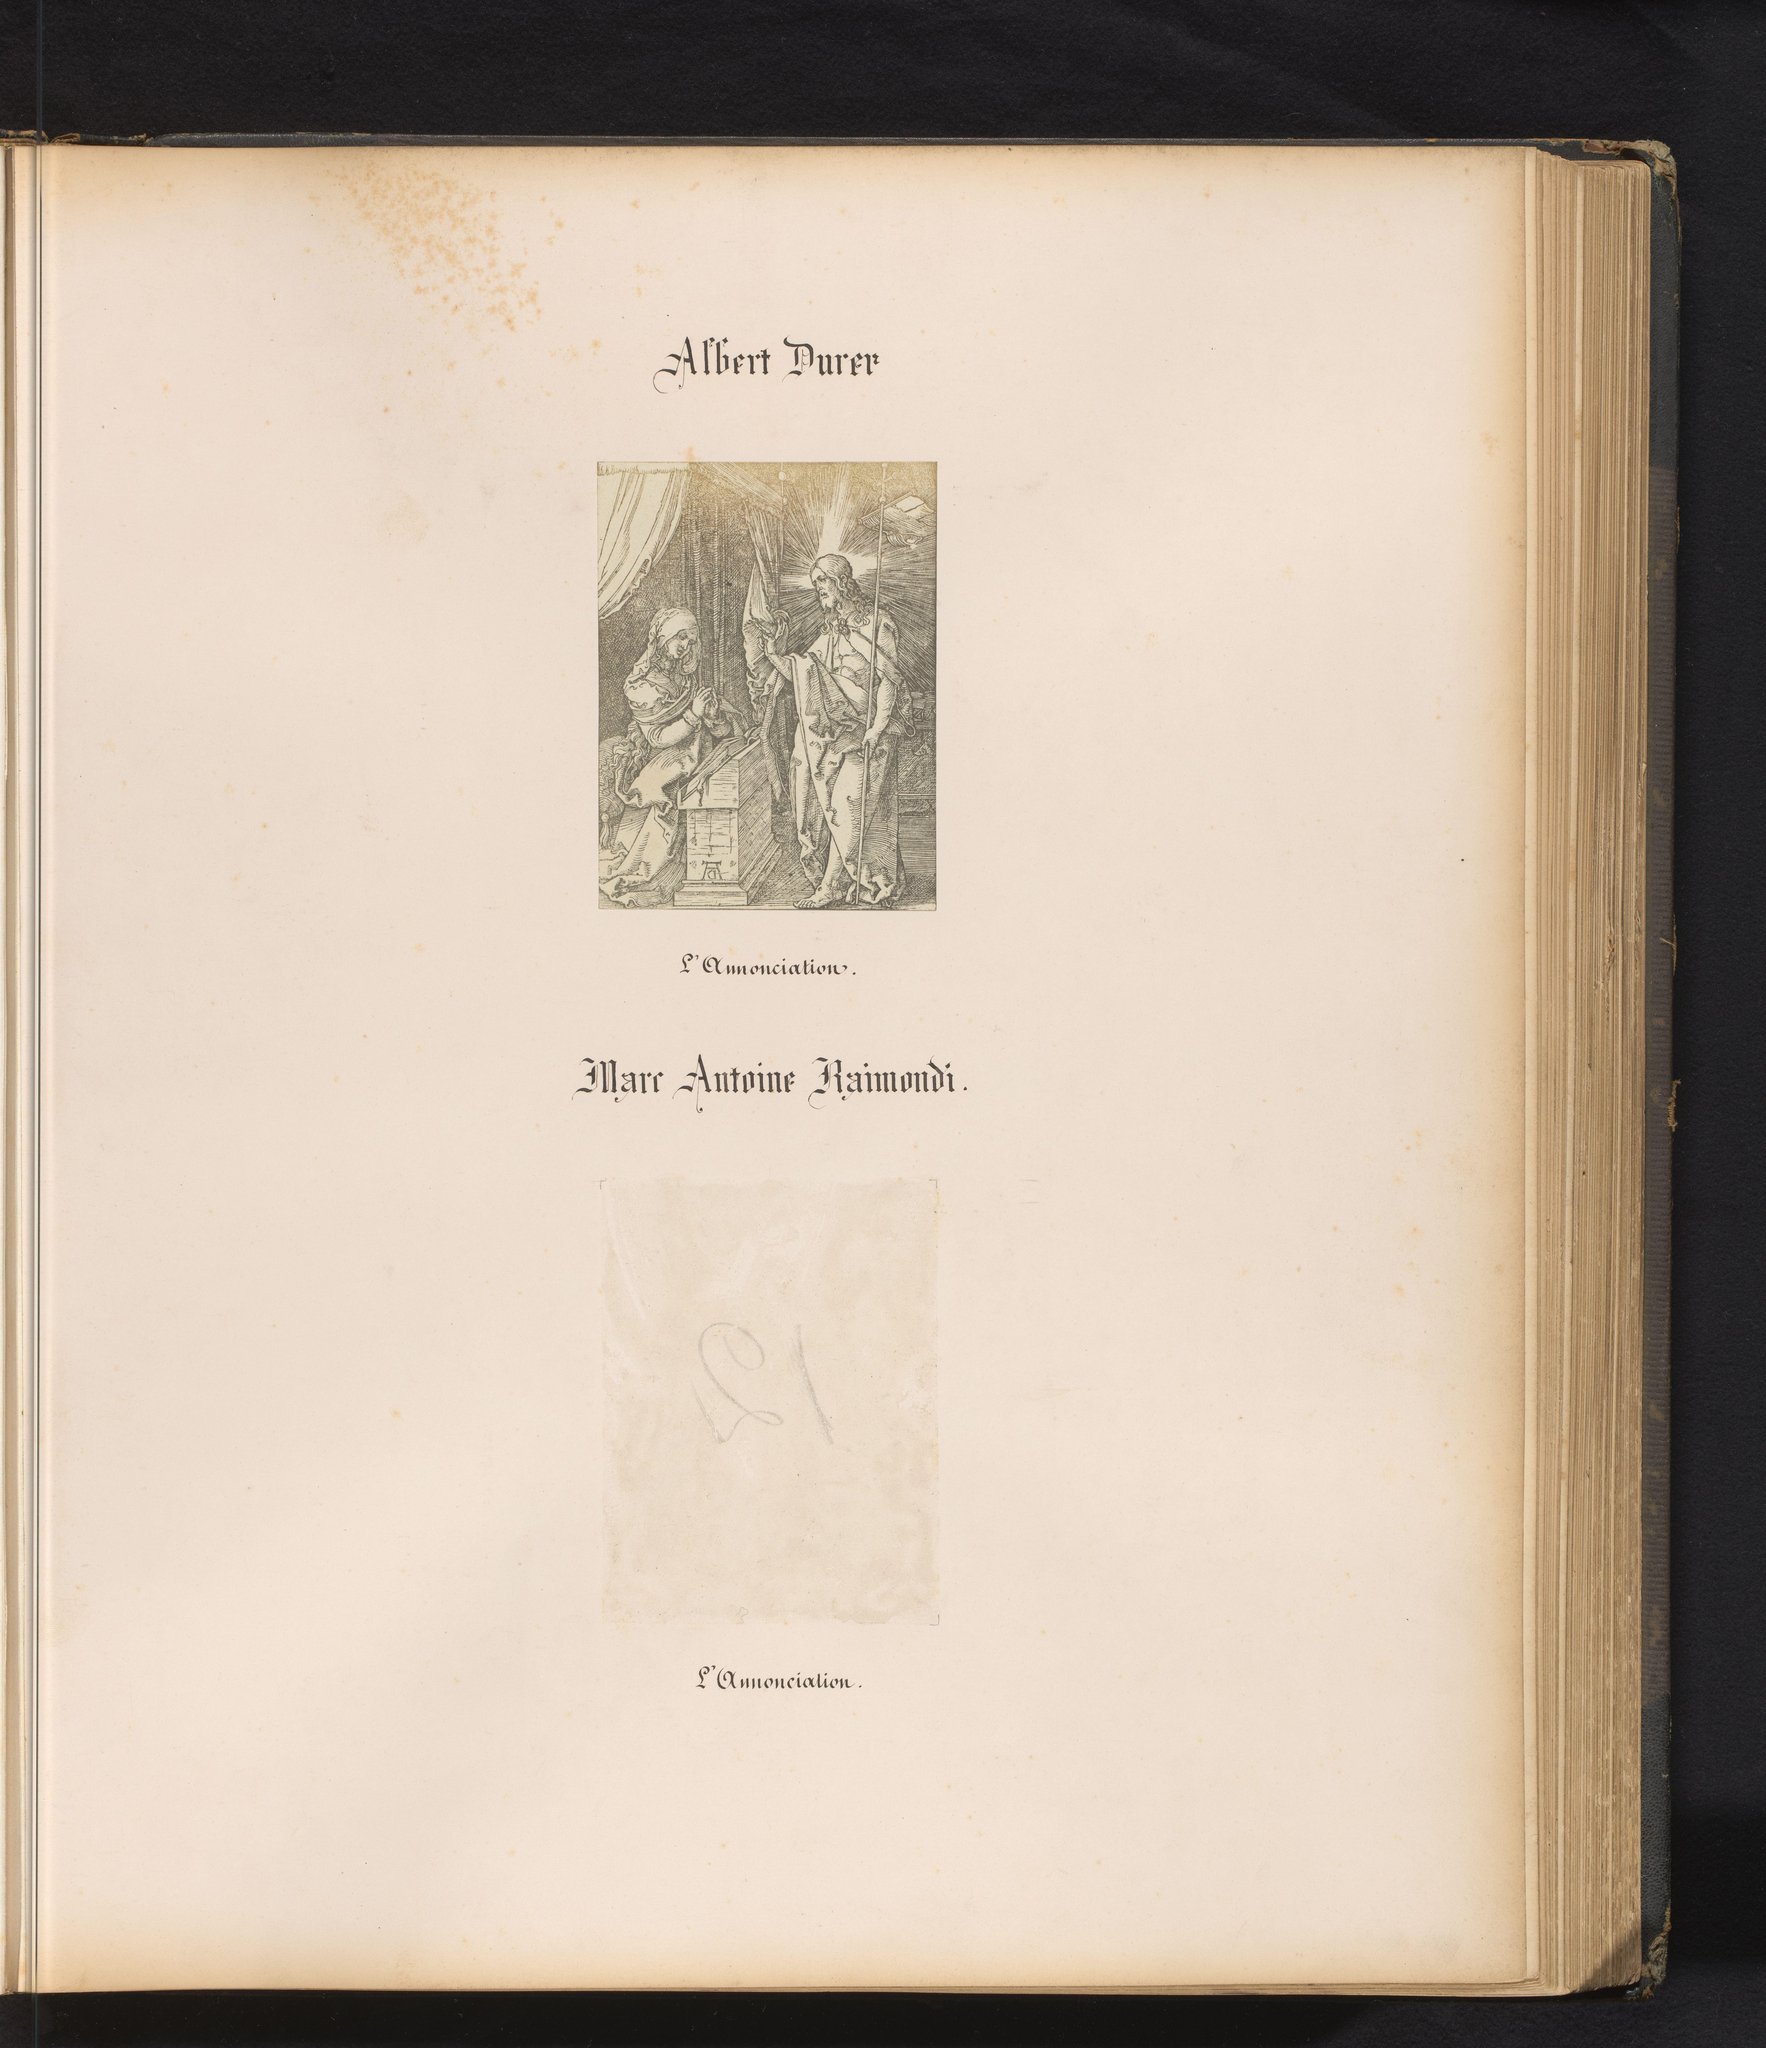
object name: photograph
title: Marc Antoine Raimondi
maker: benjamin delessert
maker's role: fotograaf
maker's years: 1817-1868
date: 1848-1853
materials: photographic support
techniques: salted paper print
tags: the annunciation: mary kneeling - aa - mary to the left, the angel to the right